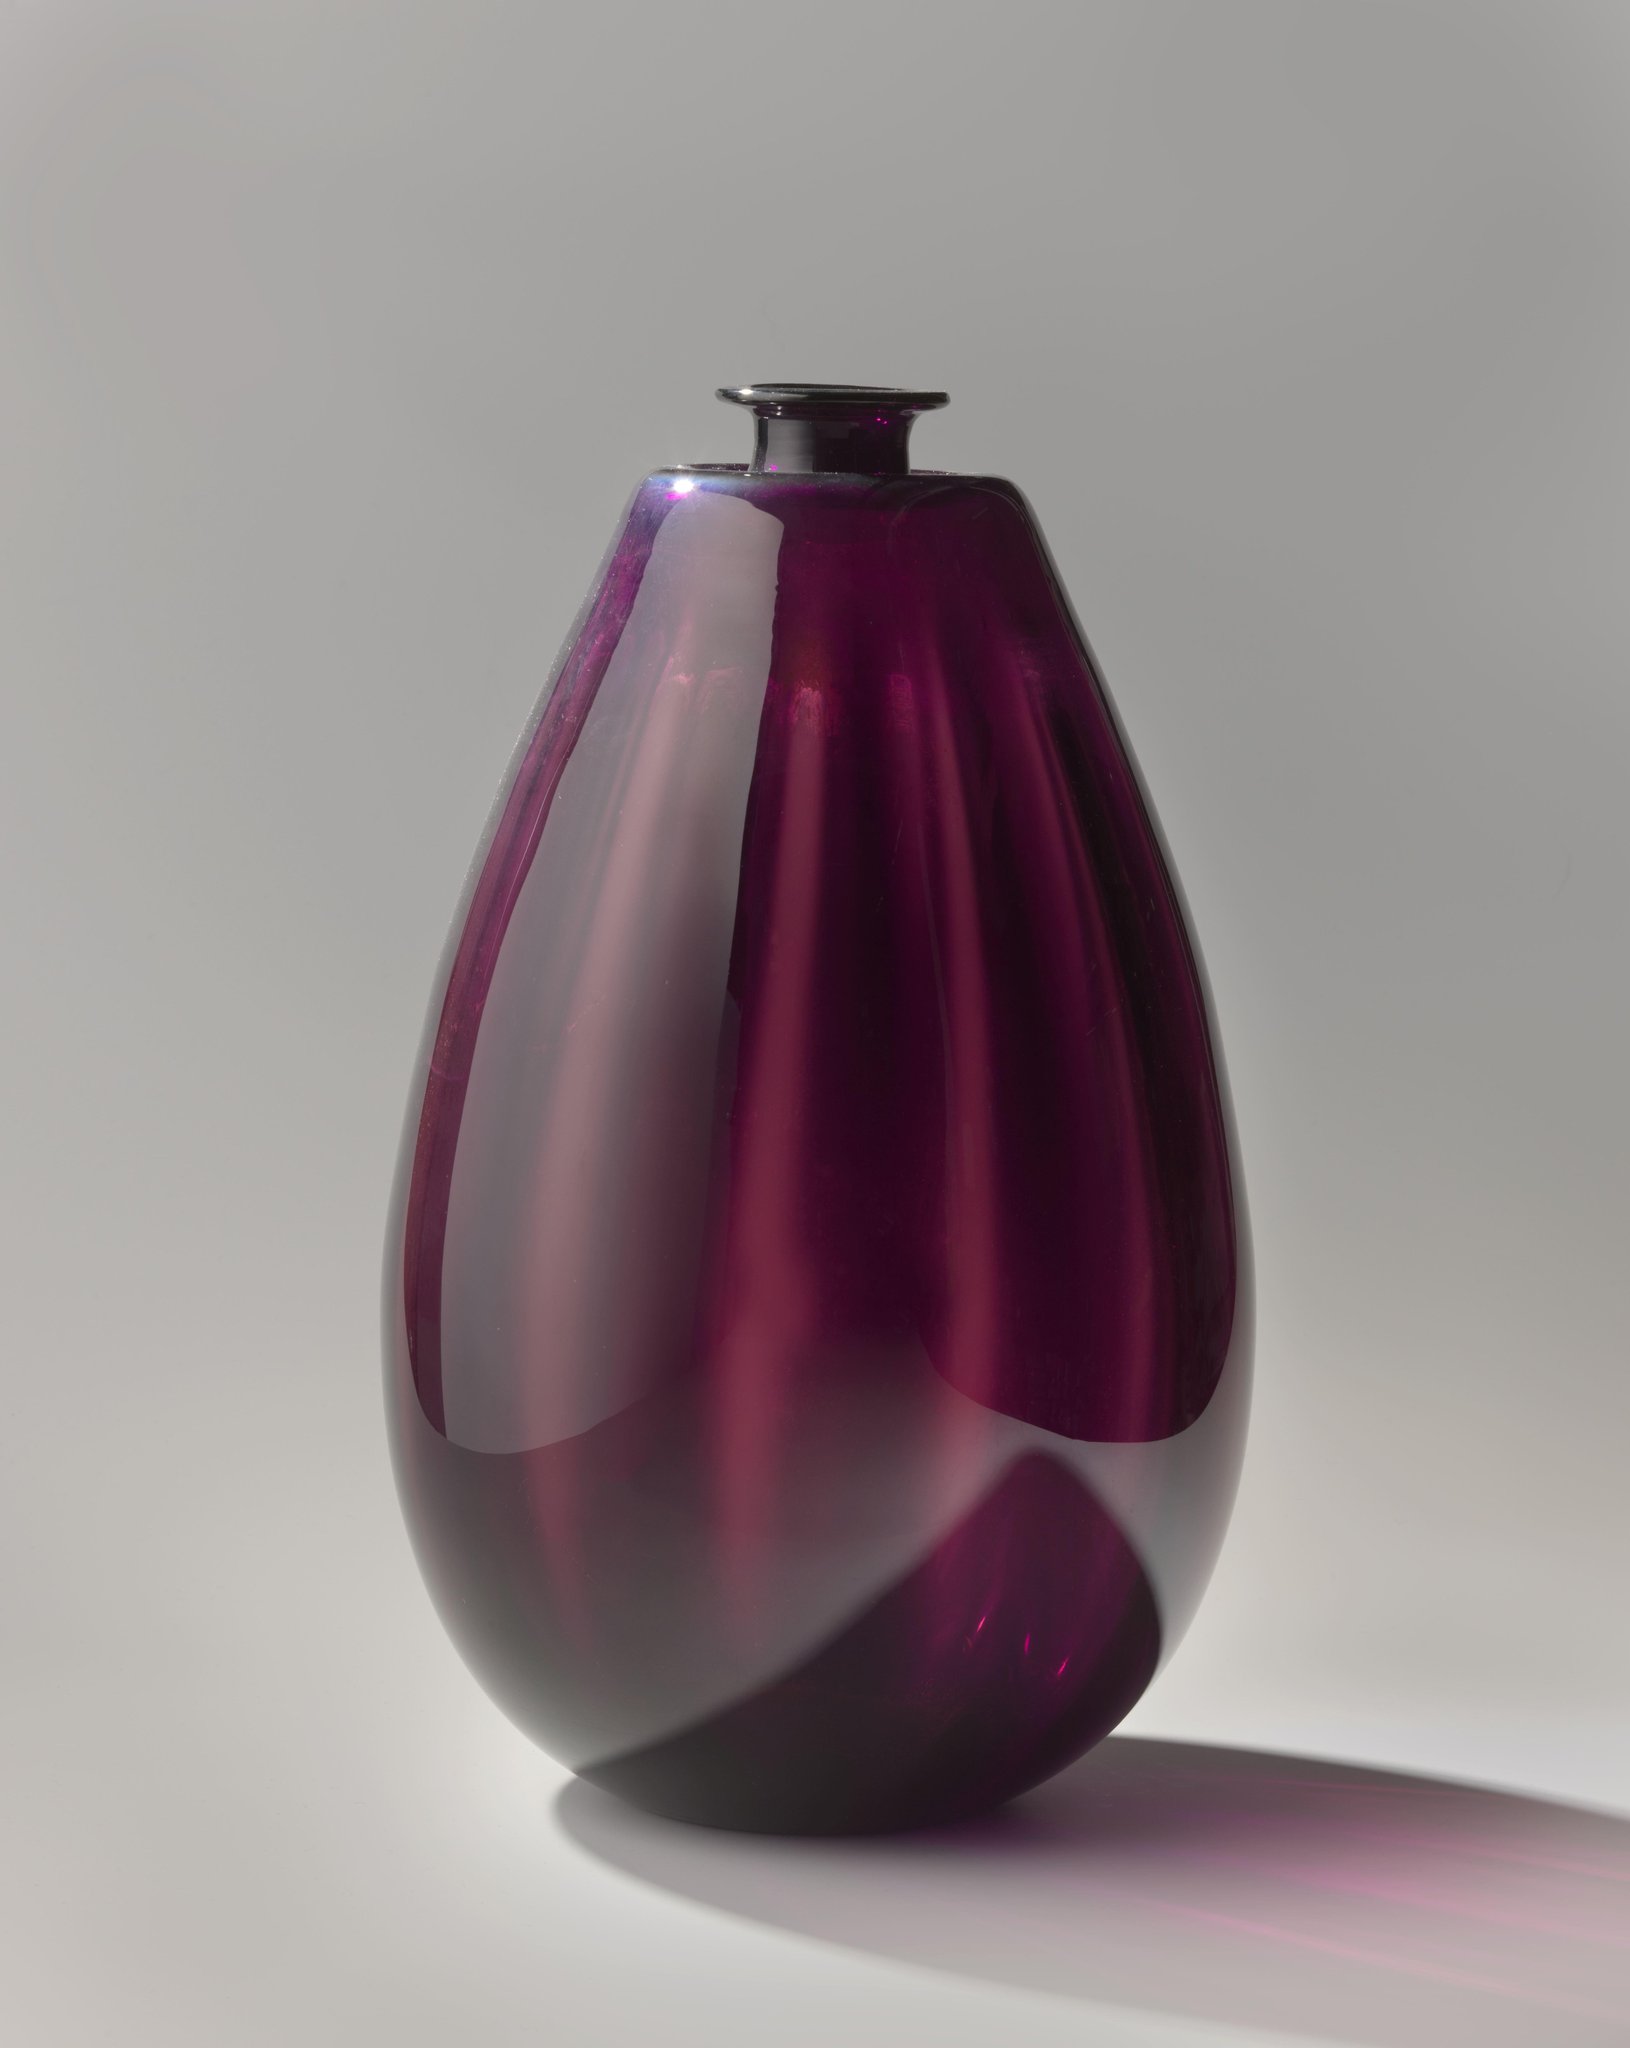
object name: vase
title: Vaas van paars glas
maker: chris lebeau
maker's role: draughtsman, print maker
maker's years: 1878-1945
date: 1924-1925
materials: glass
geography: leerdam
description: Vaas van paars glas, peervormig, met kleine opening. Fabrieksnummer: KO737.